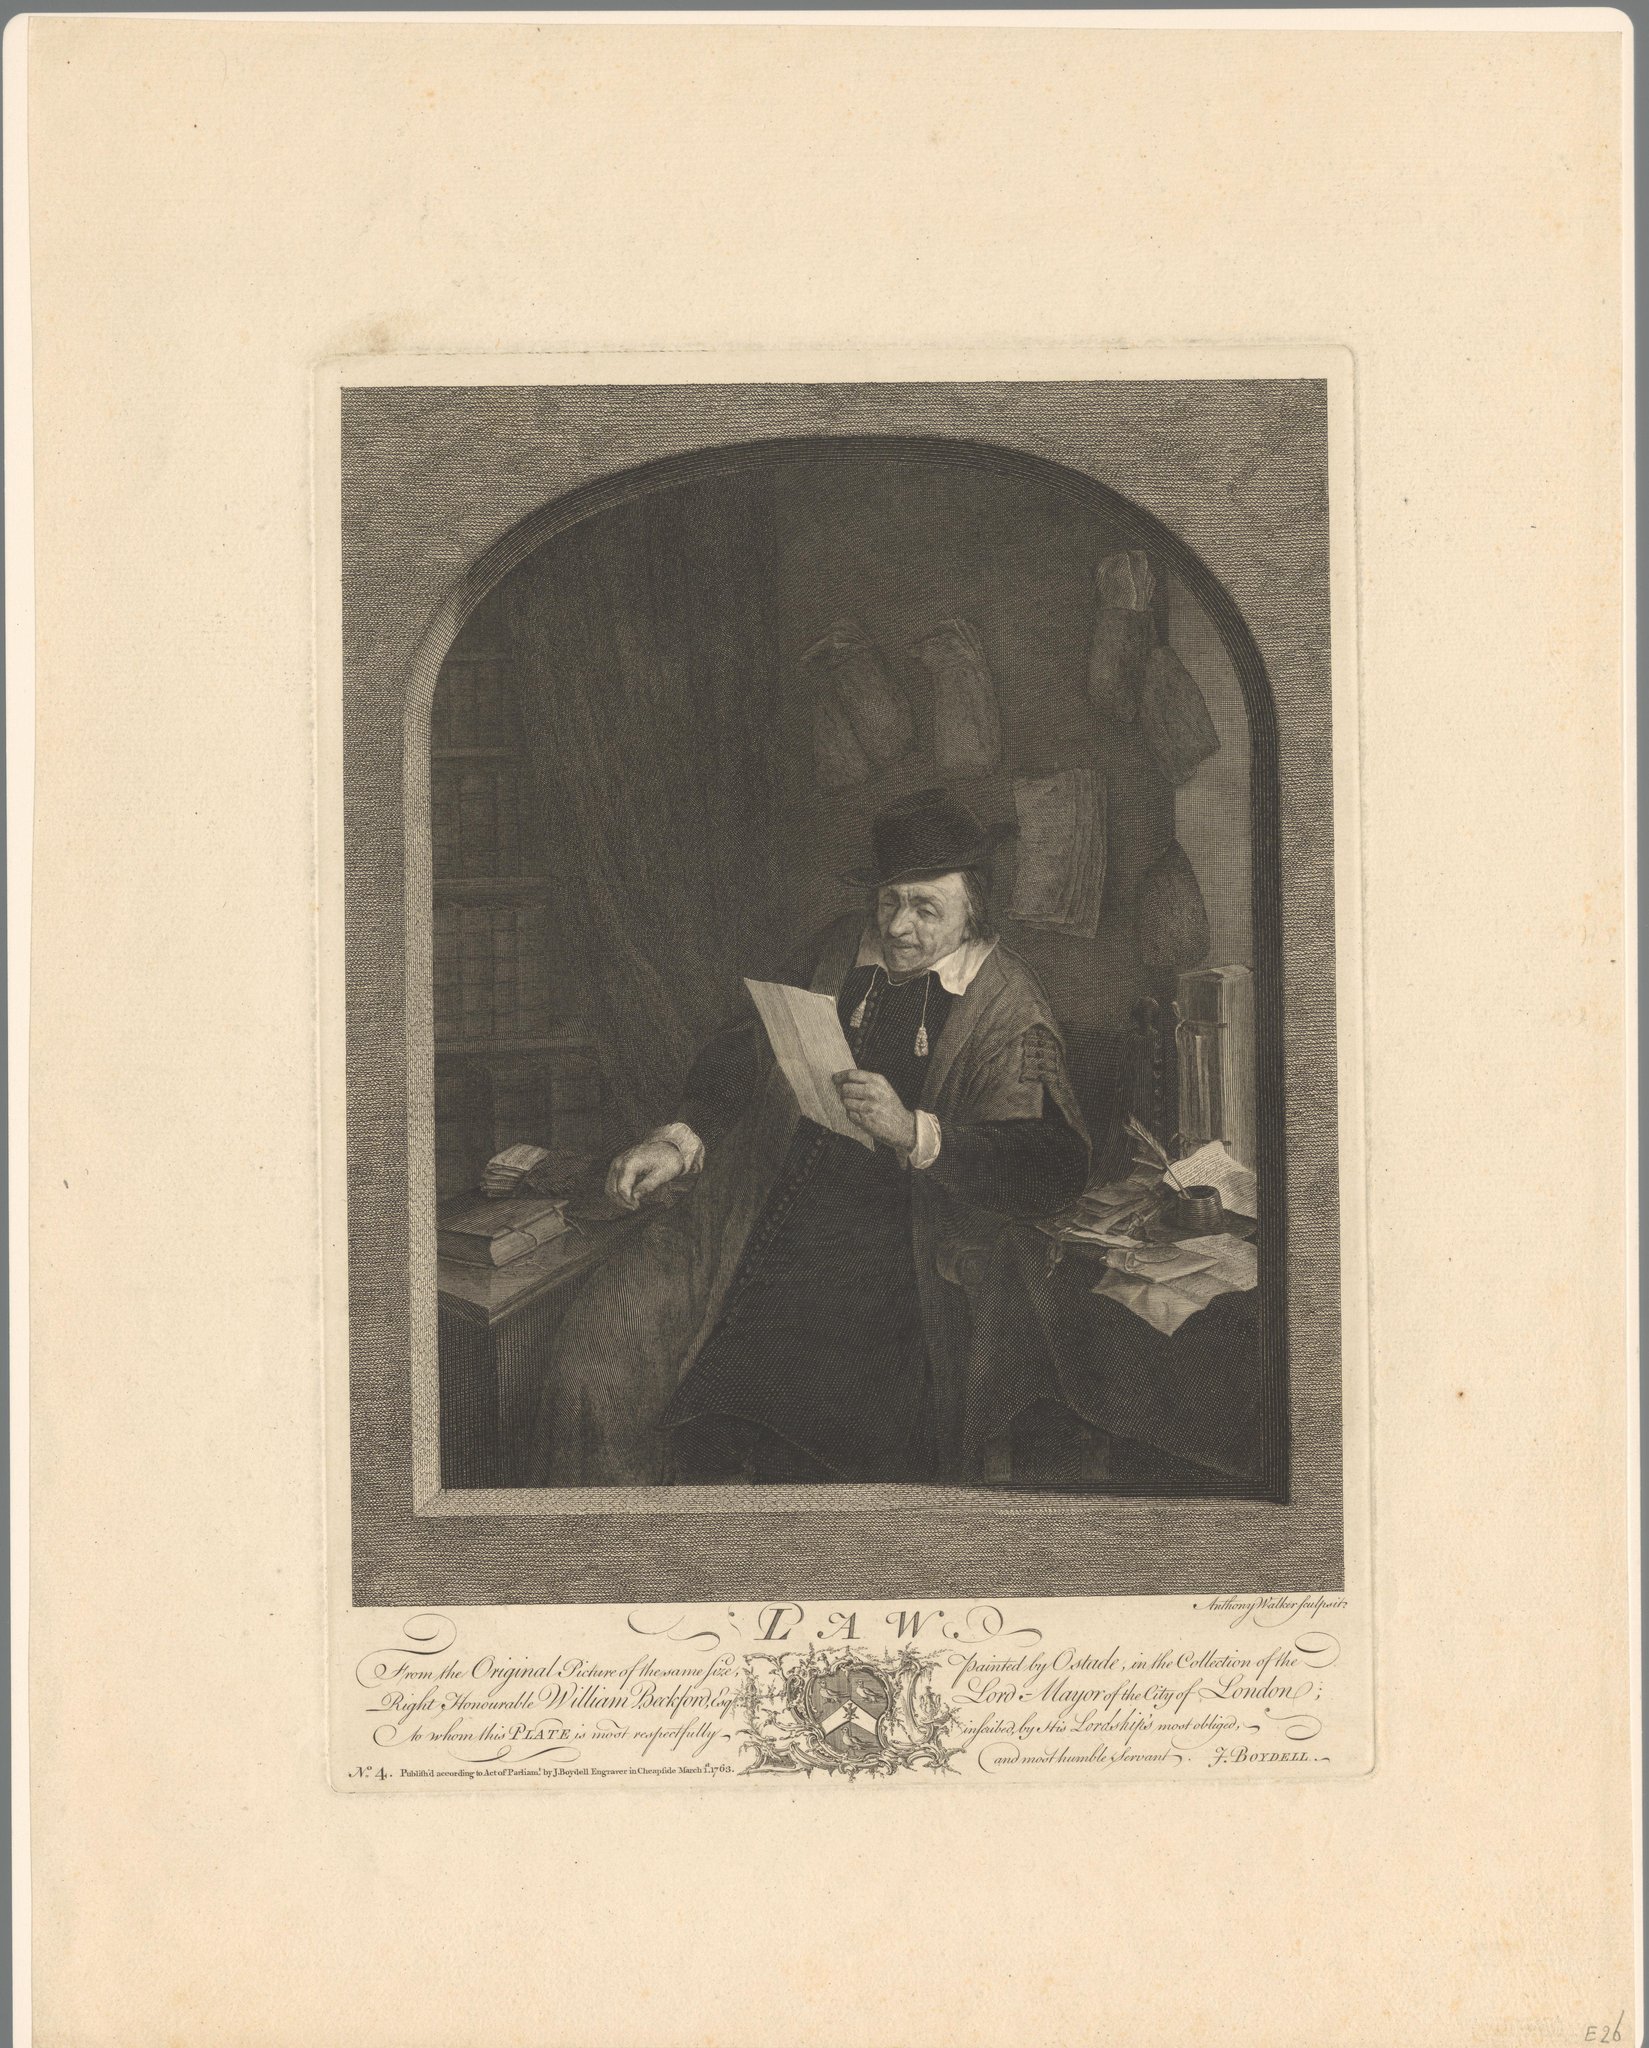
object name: print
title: Law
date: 1758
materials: paper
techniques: etching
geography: london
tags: lawyer, attorney at law, study; 'studiolo'; library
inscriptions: collector's mark: Lugt 240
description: Tekst in het Engels in de ondermarge. Genummerd: 4.